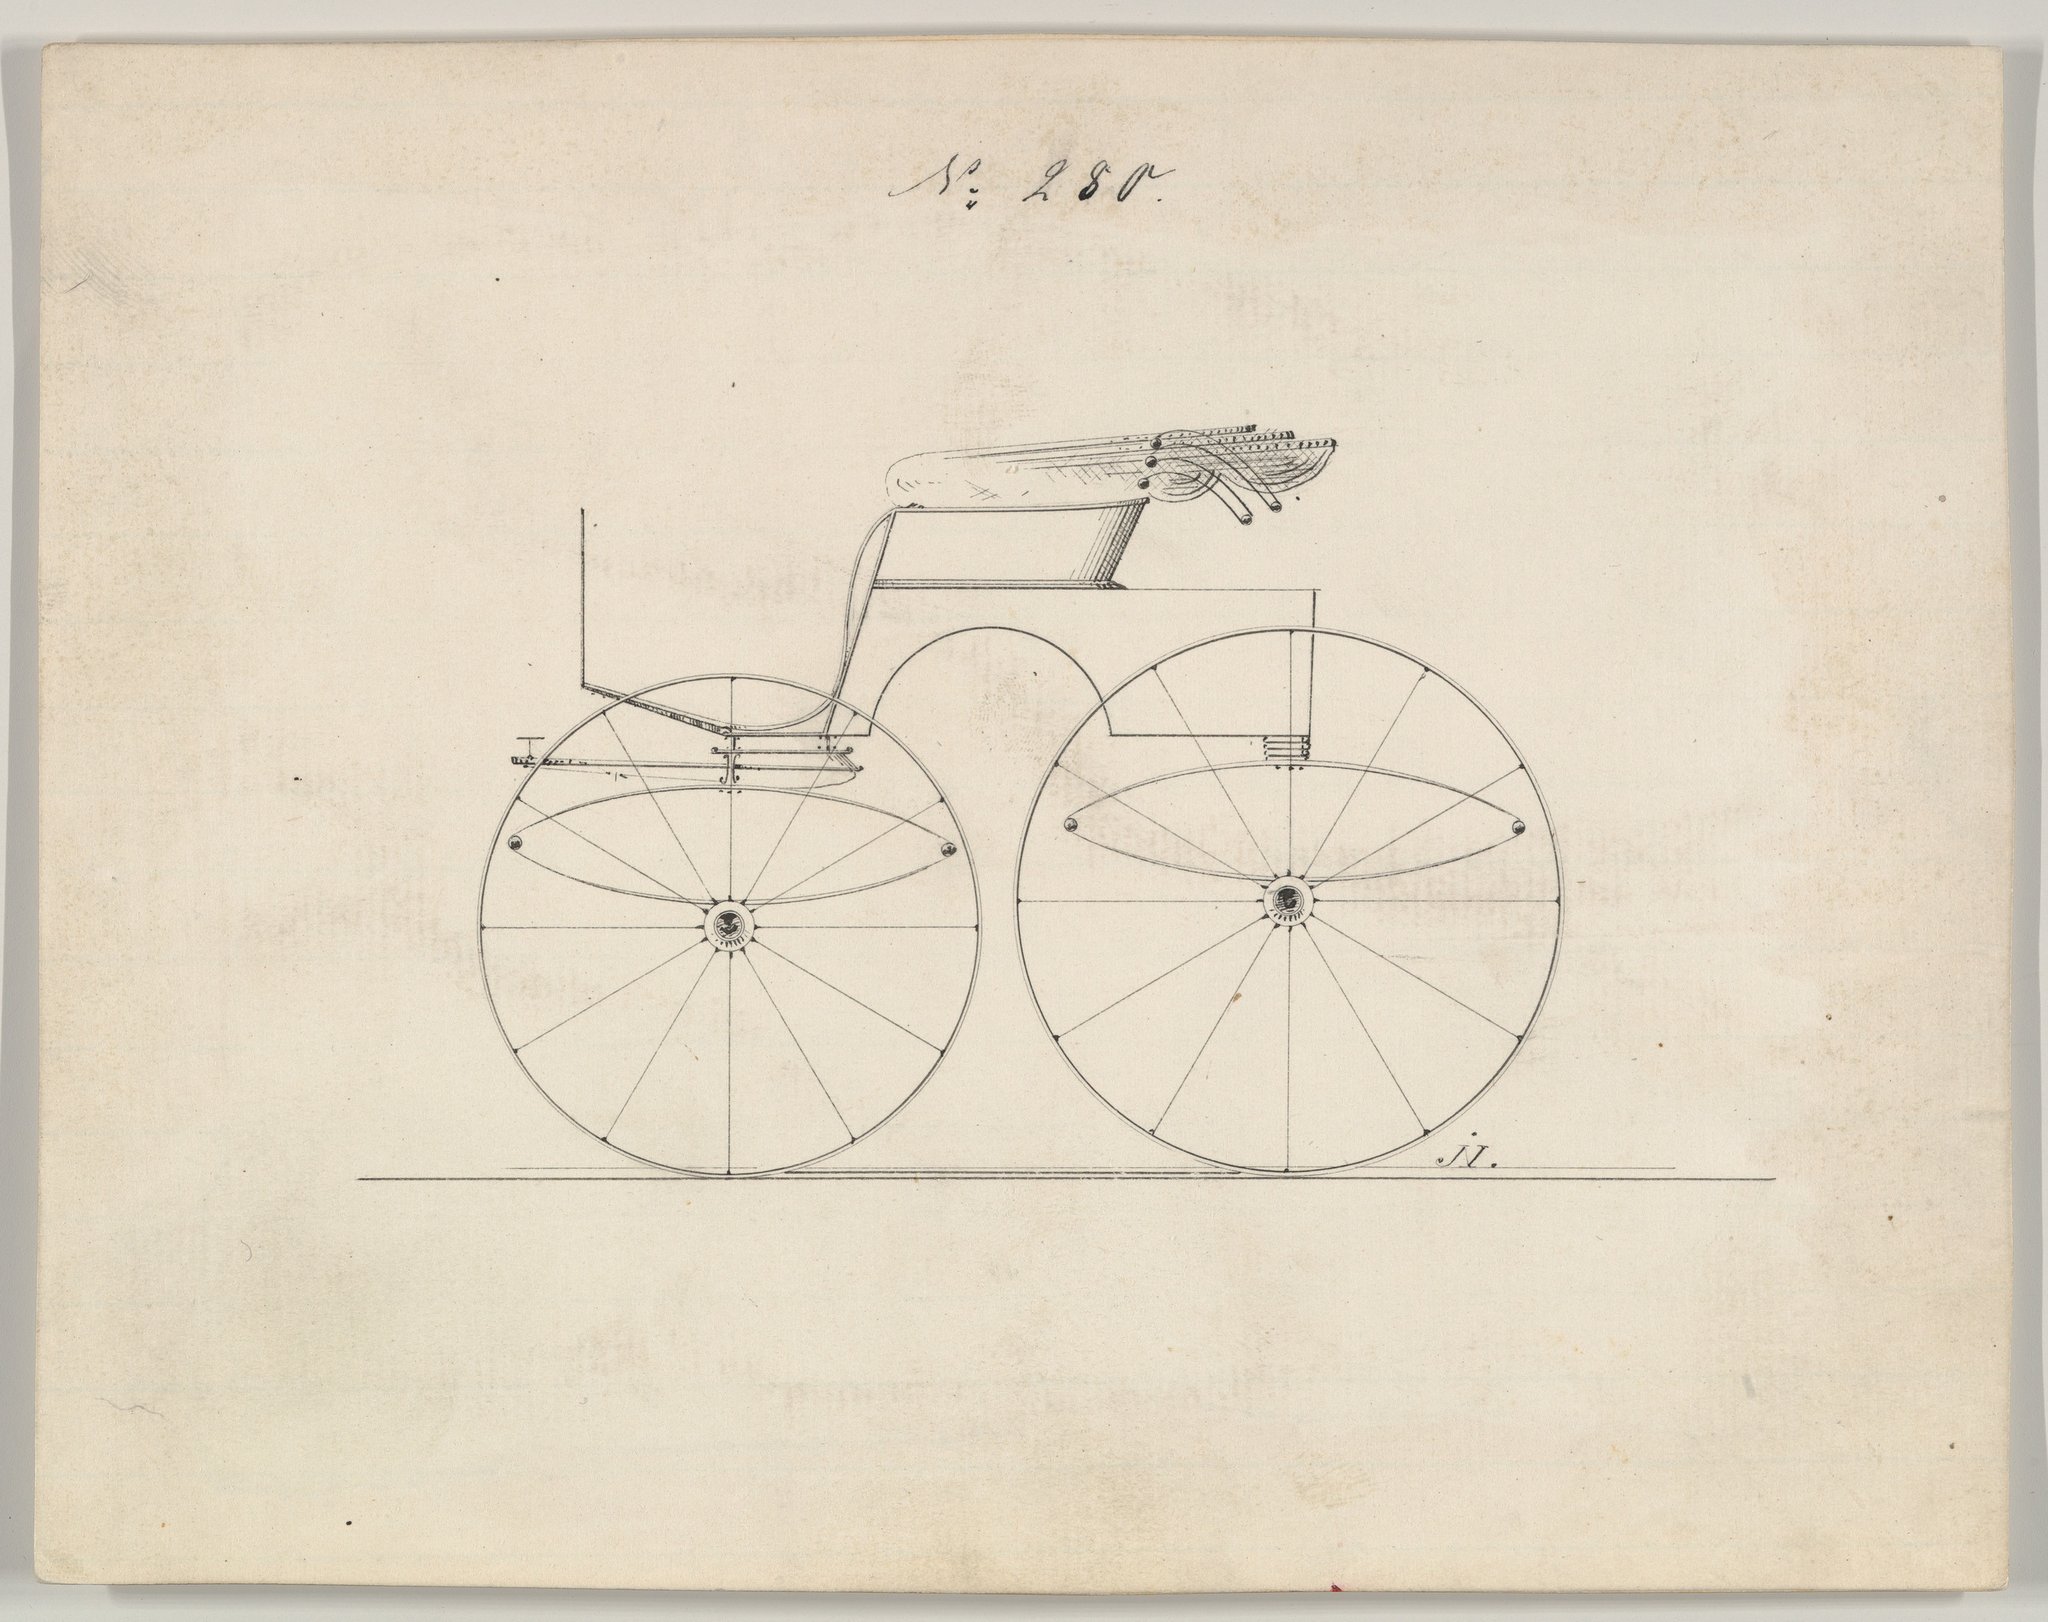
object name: drawing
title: Design for Road Wagon / Driving Phaeton, no. 280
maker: brewster & co.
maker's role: manufacturer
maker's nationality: american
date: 1850-1870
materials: ink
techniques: pen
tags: carriages